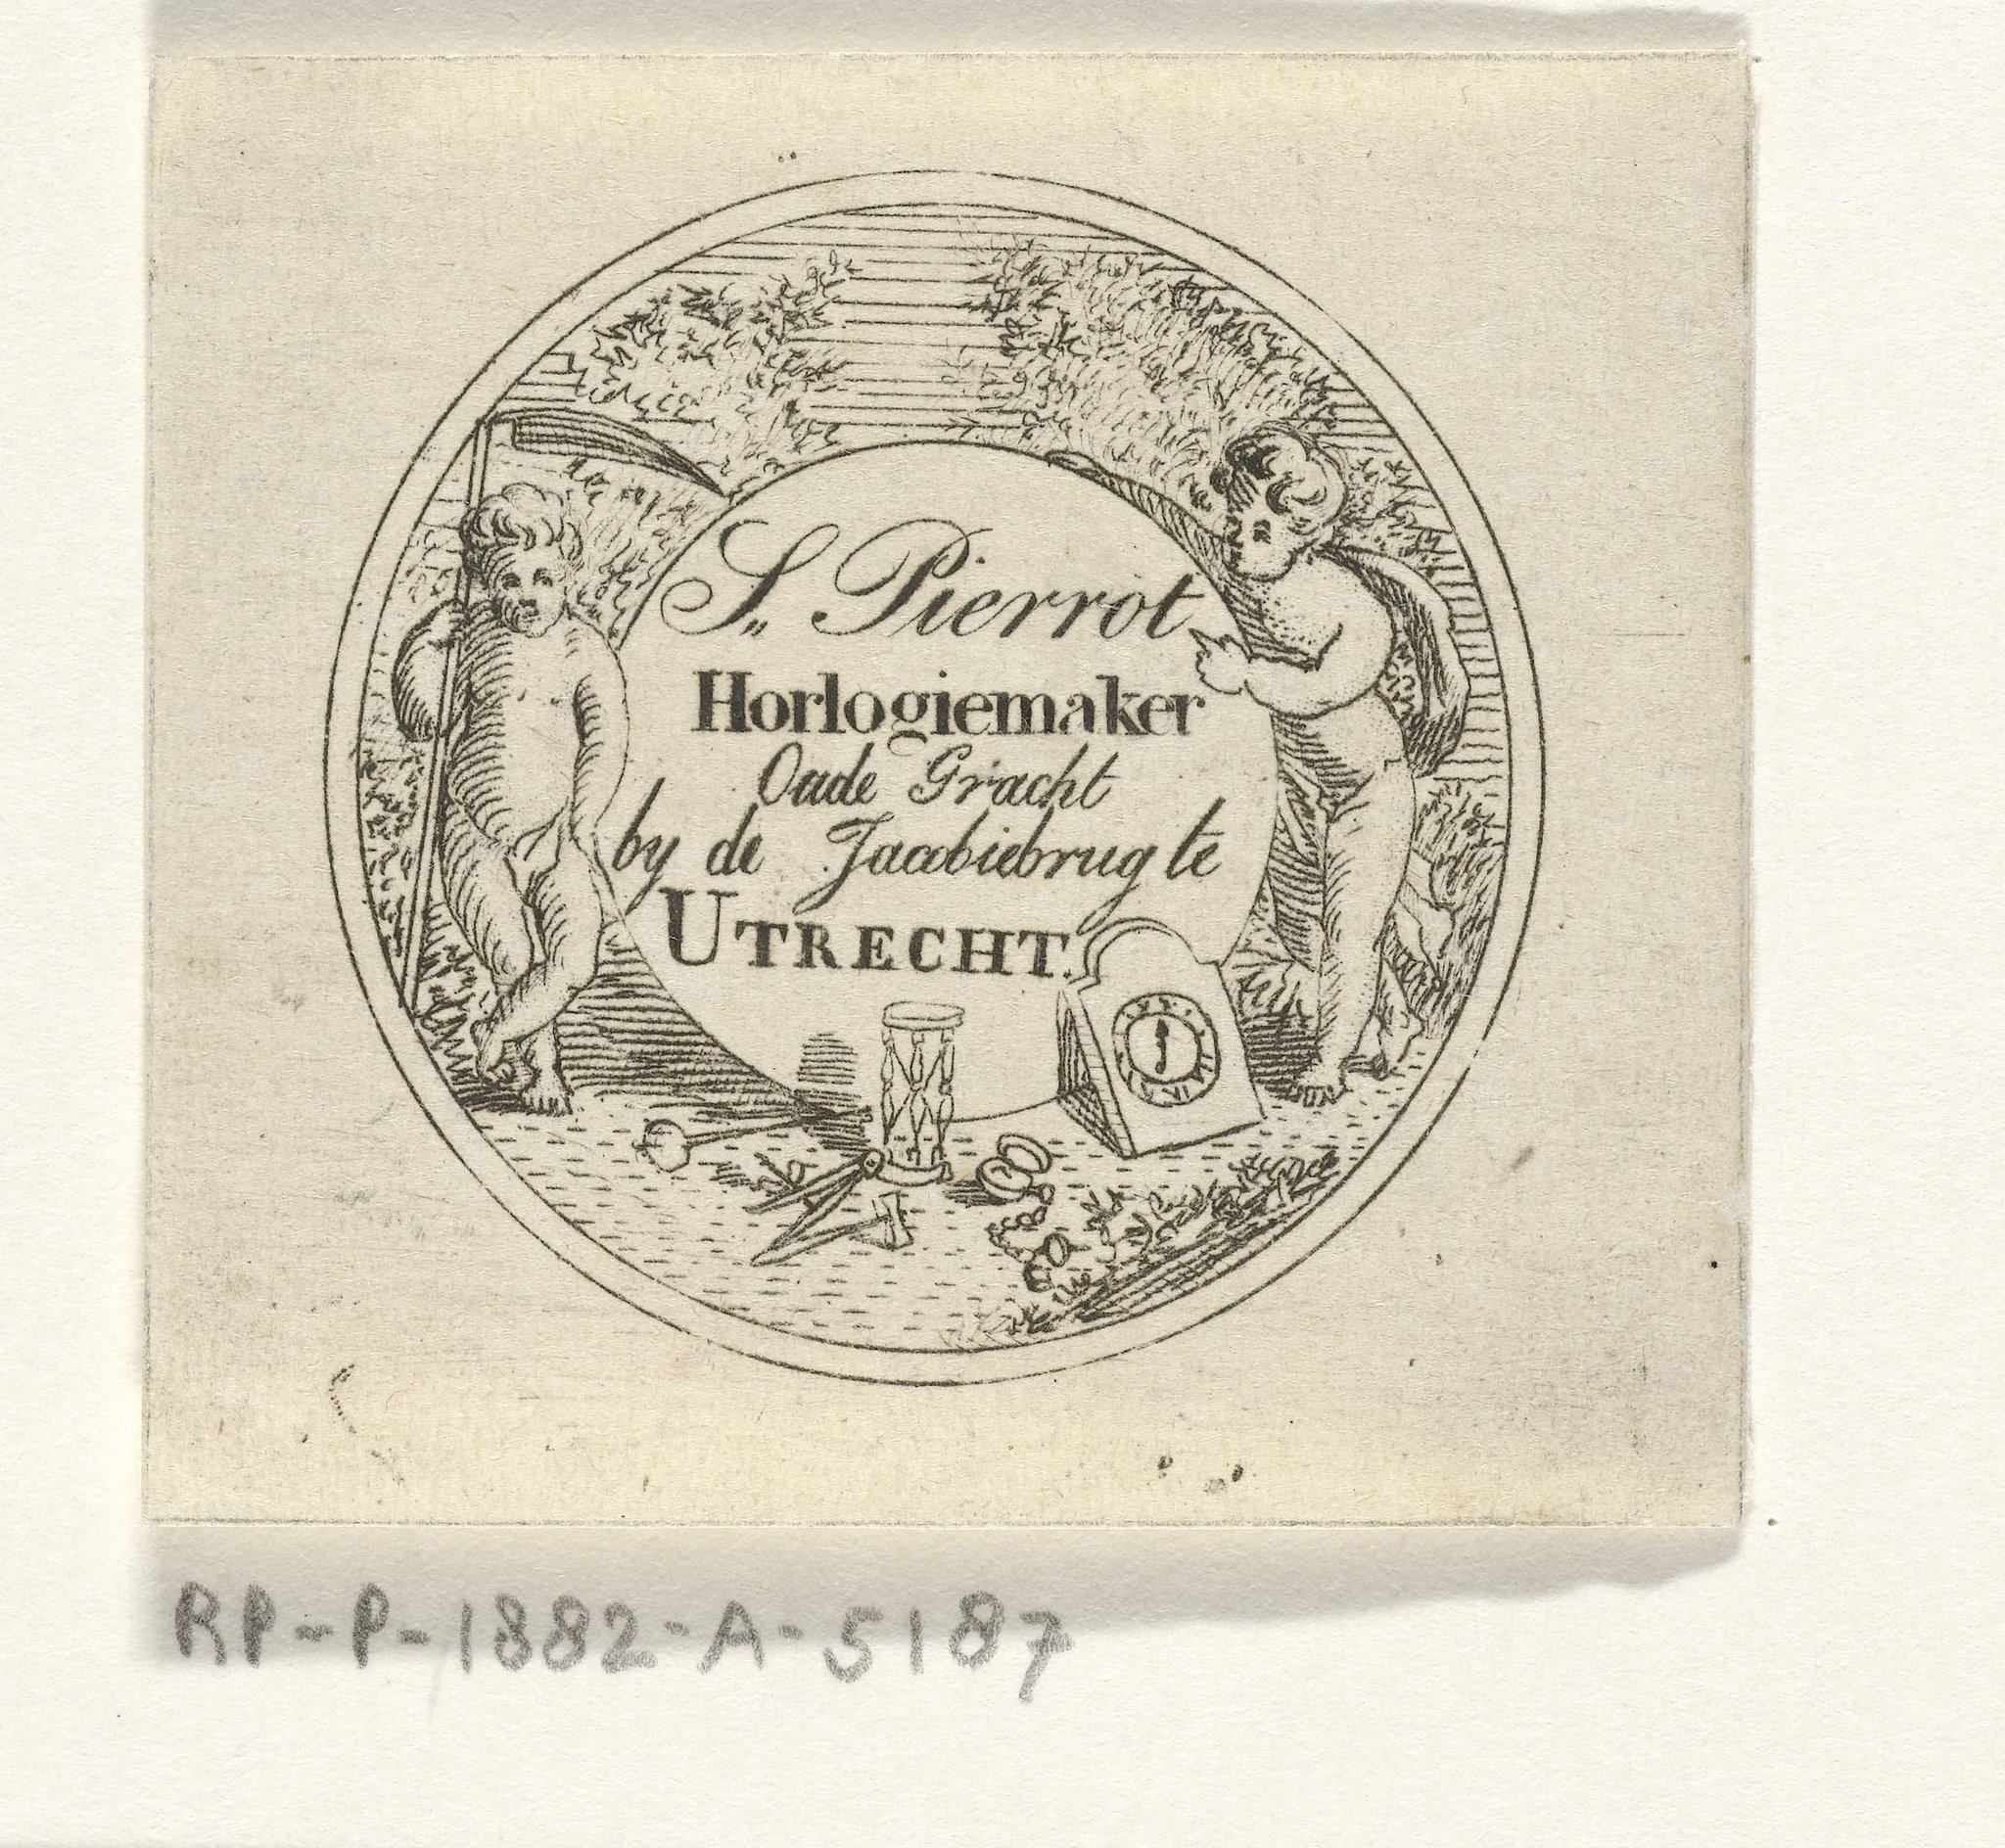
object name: print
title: Visitekaartje van horlogemaker S. Pierrot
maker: david van der kellen (1804-1879)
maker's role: die cutter, draughtsman, print maker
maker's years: 1804-1879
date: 1814-1879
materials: paper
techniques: etching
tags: hourglass, agricultural implements, other allegories of time, e.g. 'tempo' (ripa), watchmaker, clockmaker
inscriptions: collector's mark: Lugt 2228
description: Cirkelvorming visitekaartje van de horlogemaker S. Pierrot, gehuisvest aan de Oude Gracht bij de Jacobiebrug te Utrecht. Om het adres heen is een allegorie op de tijd afgebeeld. Onder het adres staan een zandloper, een zakhorloge en een klok en naast het adres staan twee putti, waarvan de linker een zeis in zijn hand heeft.